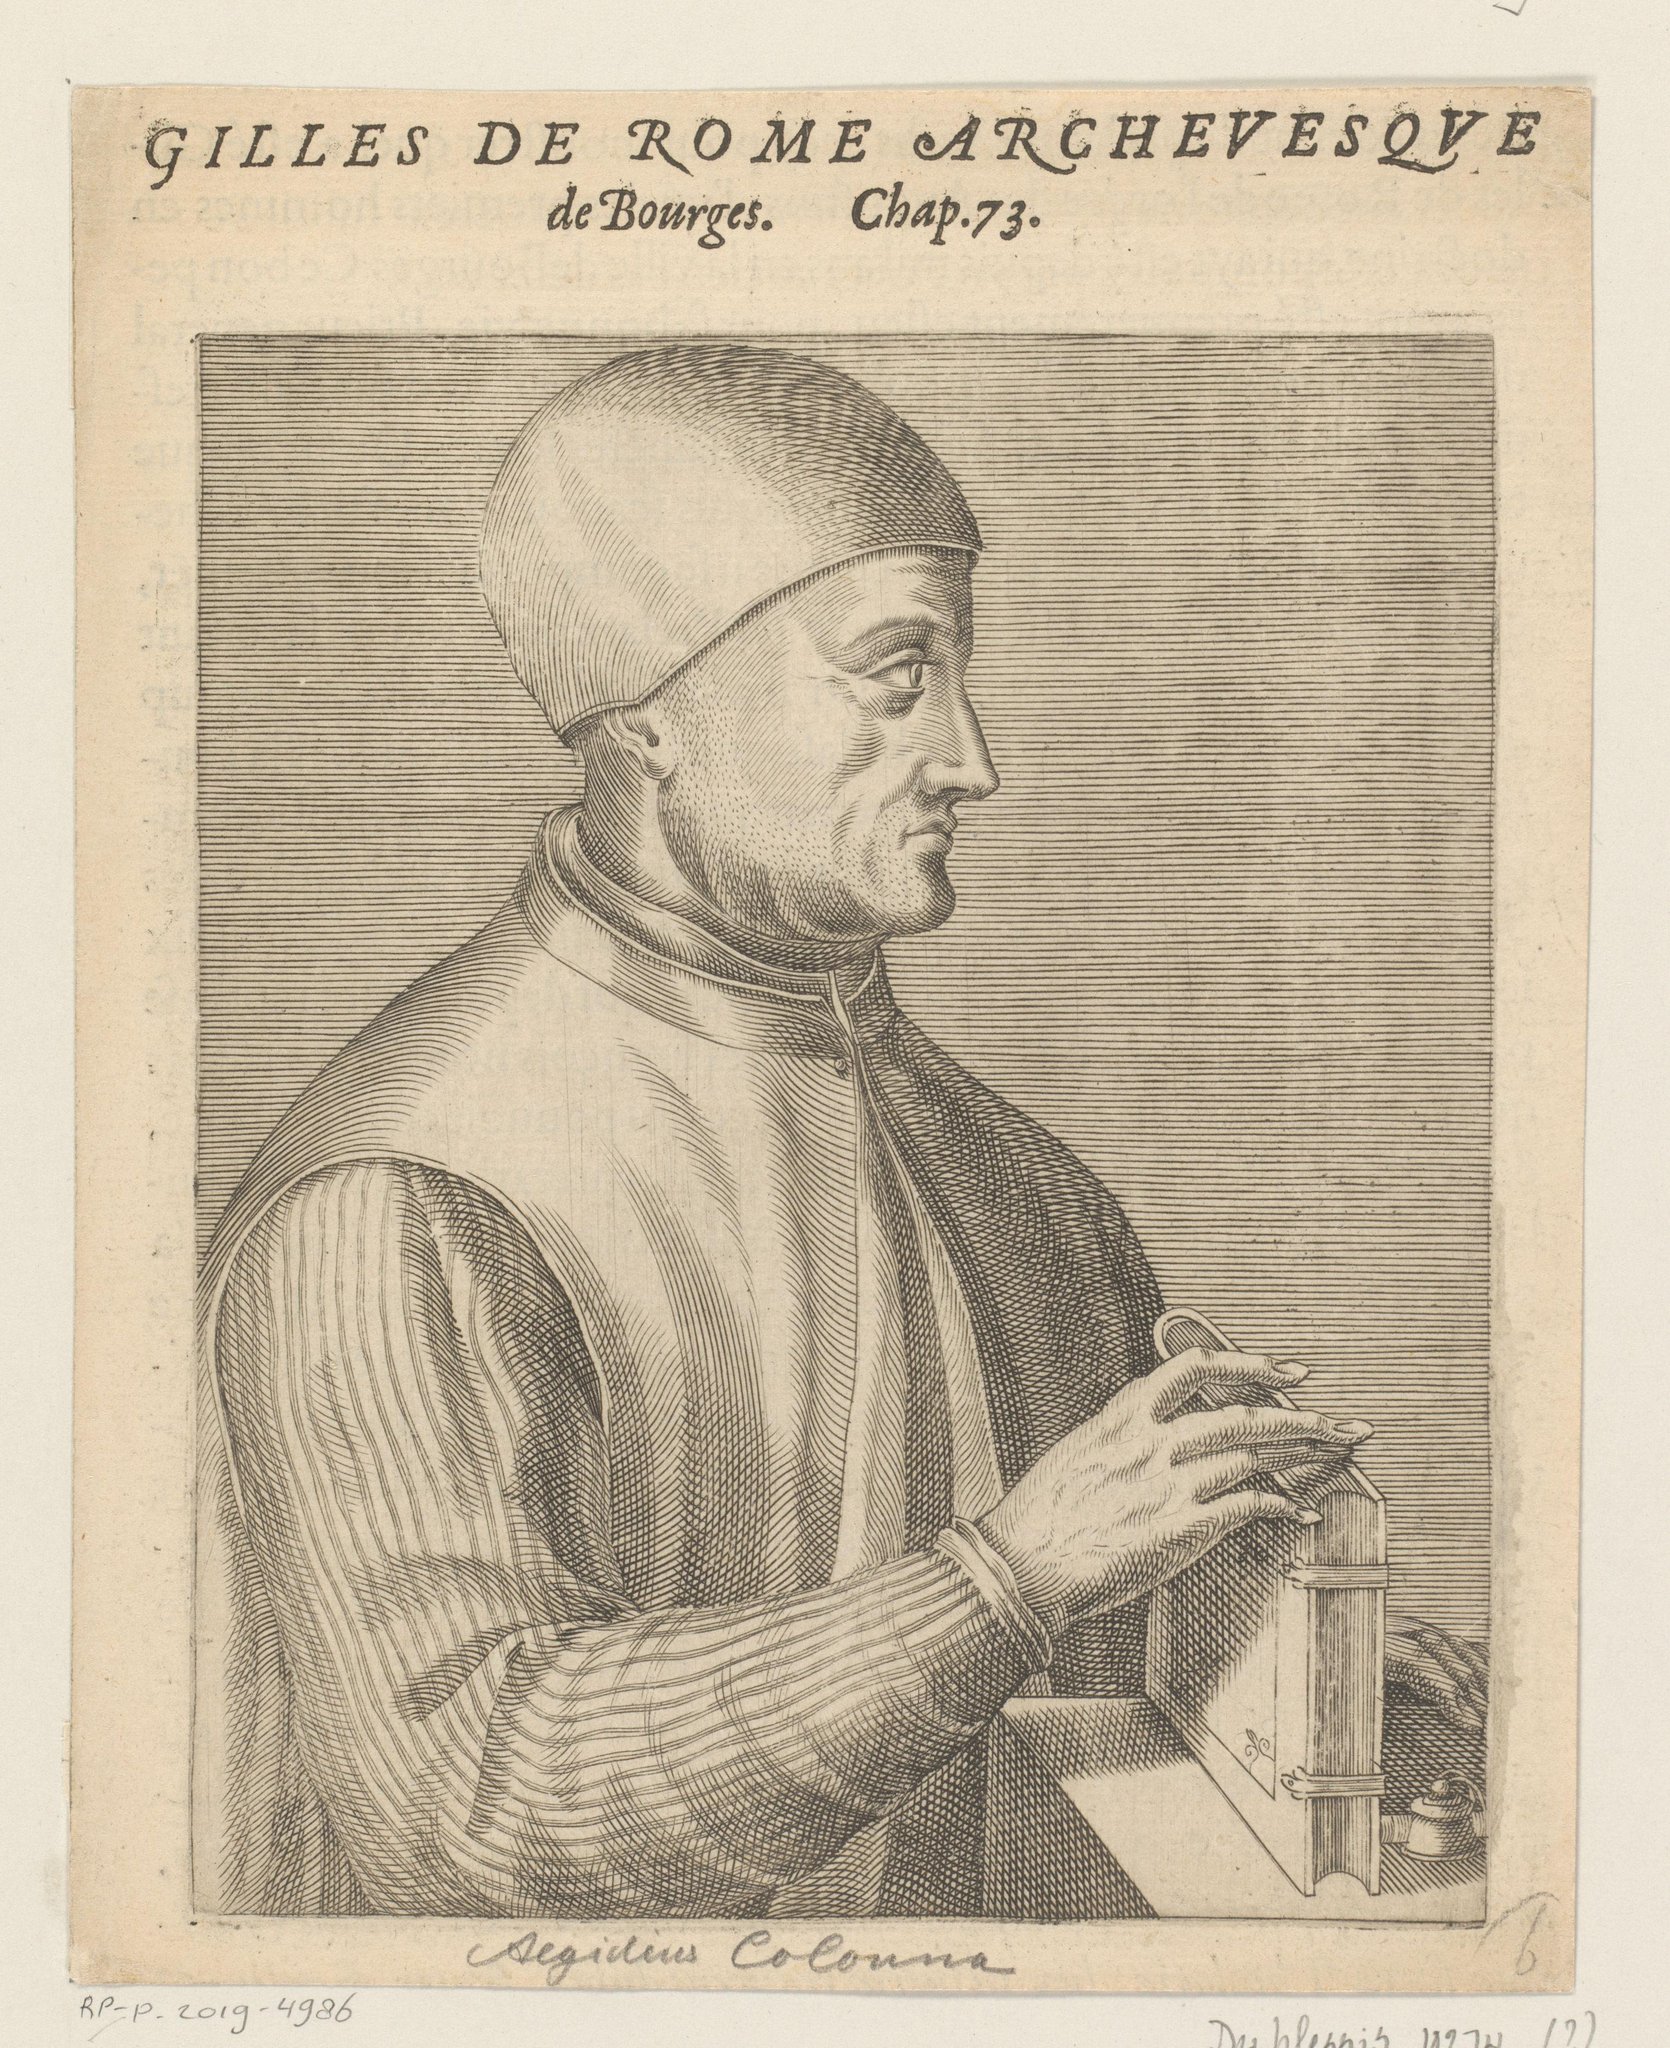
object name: print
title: Portret van Aegidius Romanus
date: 1584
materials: paper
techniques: engraving, etching, letterpress printing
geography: paris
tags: historical persons, book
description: Prent uit: Thevet, André. Les vrais pourtraits et vies des hommes illustres grecz, latins et payens (...). Parijs: weduwe Jacques Kerver en Guillaume Chaudière, 1584, dl. 1, f. 149.